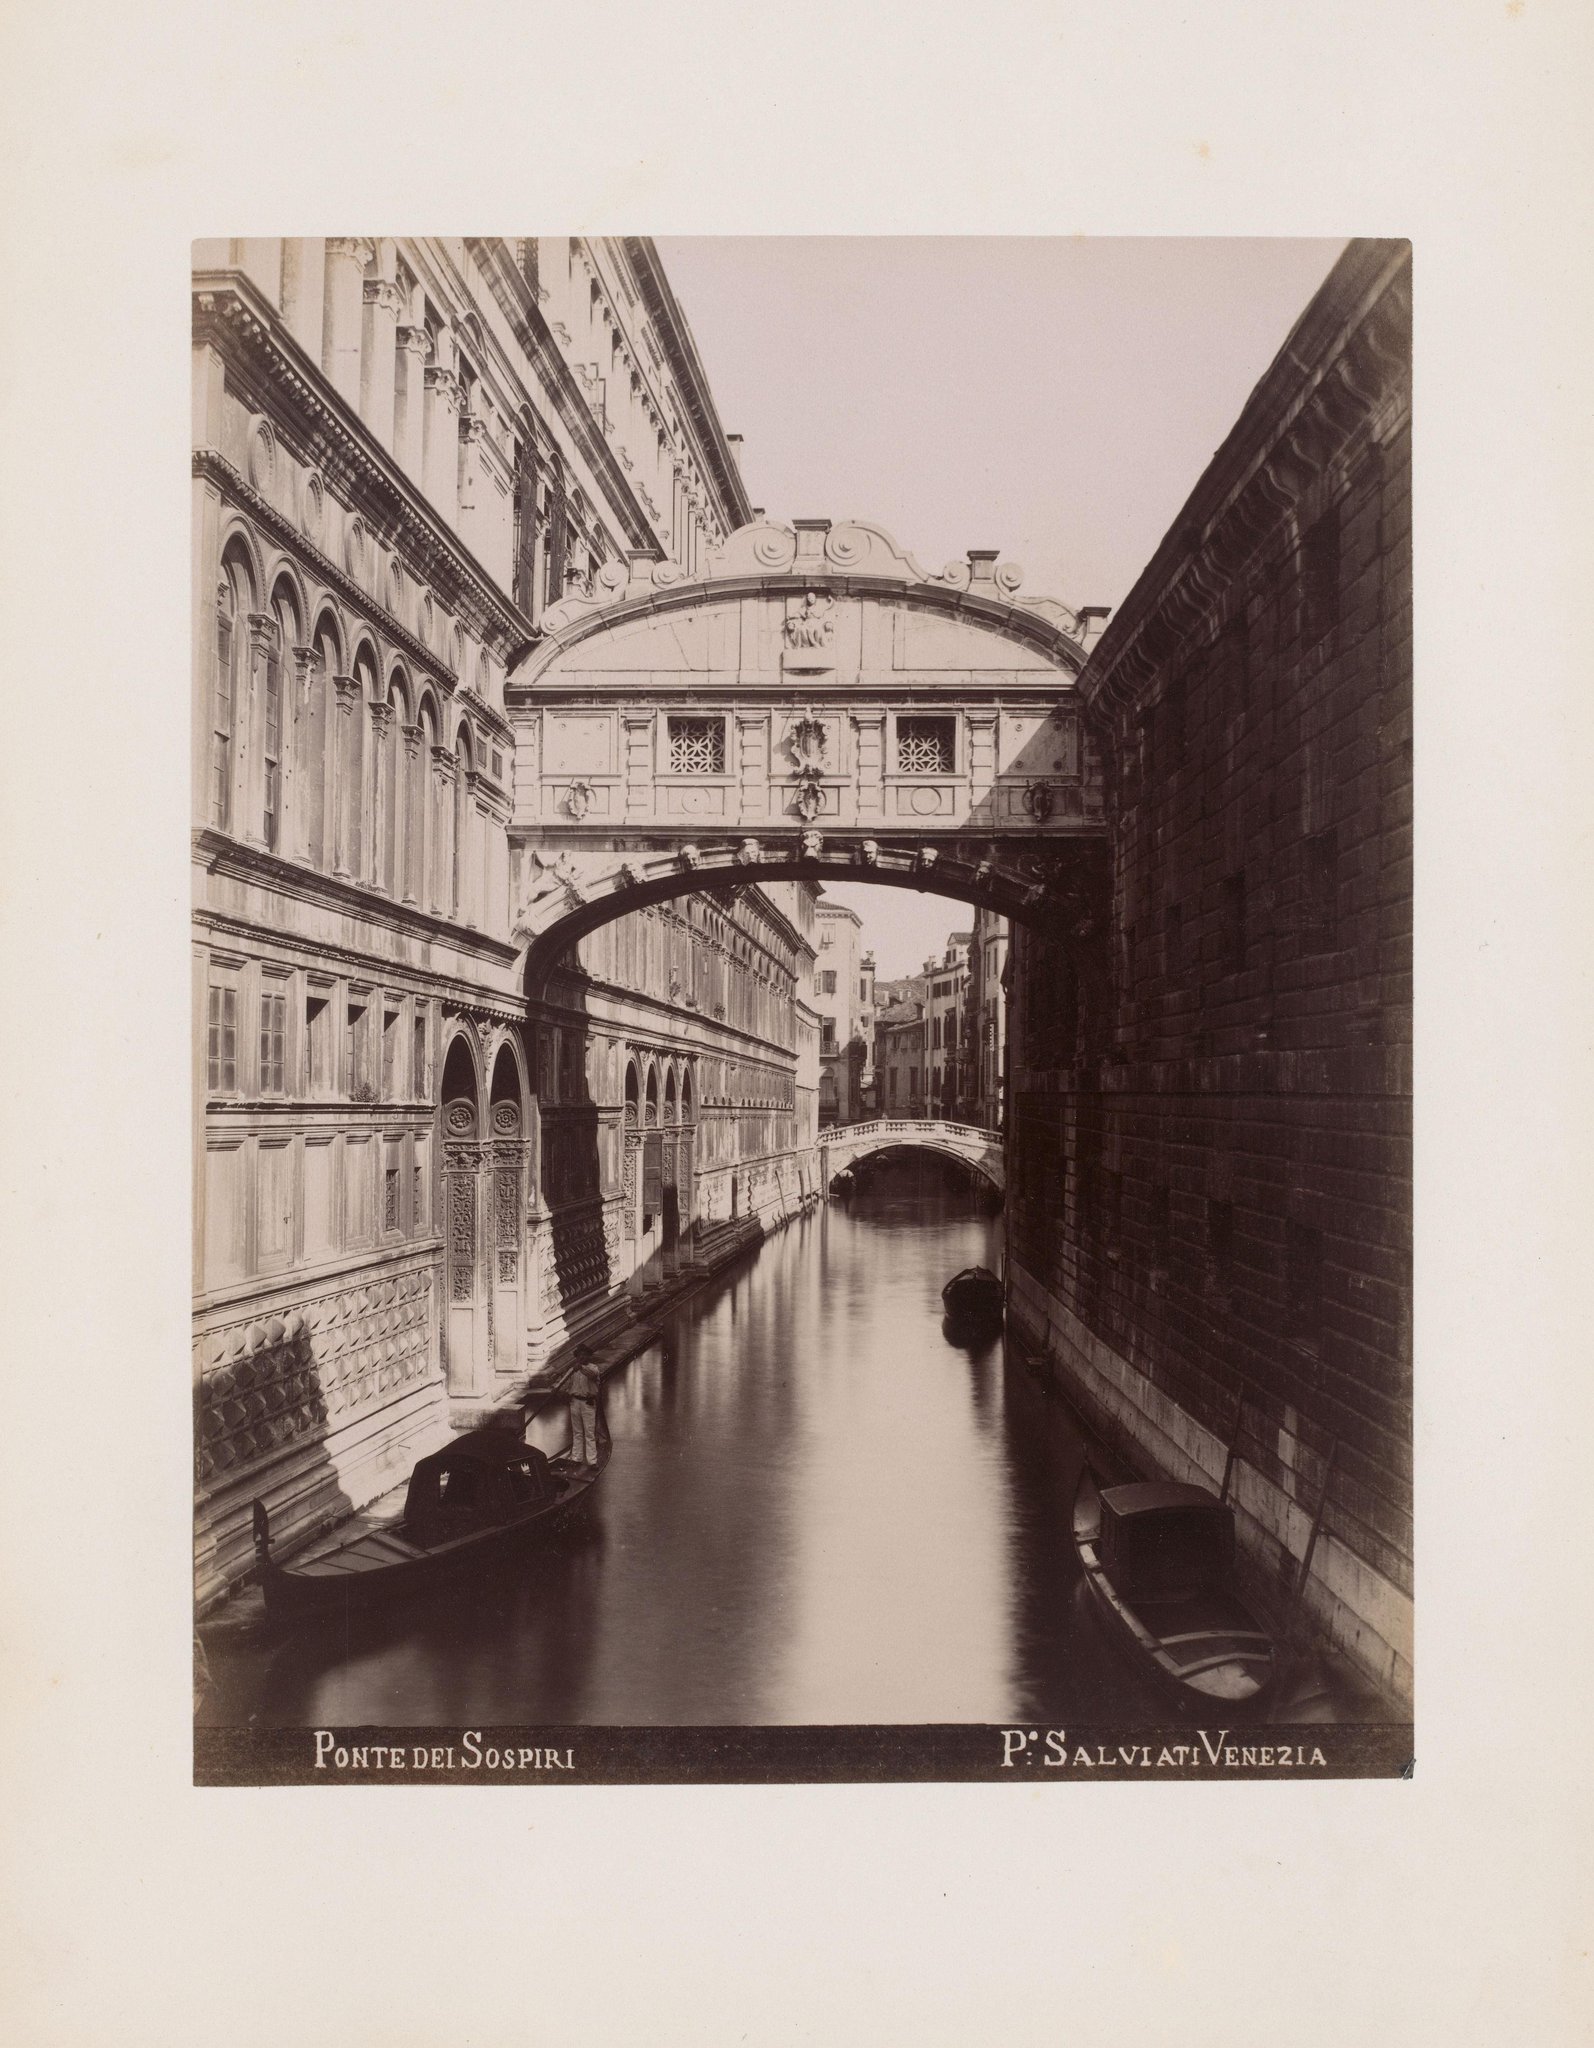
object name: photograph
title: Brug der Zuchten te Venetië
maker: paolo salviati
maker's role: fotograaf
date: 1860-1870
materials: cardboard, paper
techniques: albumen print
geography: venice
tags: bridge in city across river, canal, etc.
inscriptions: inscription: ‘Venetie’